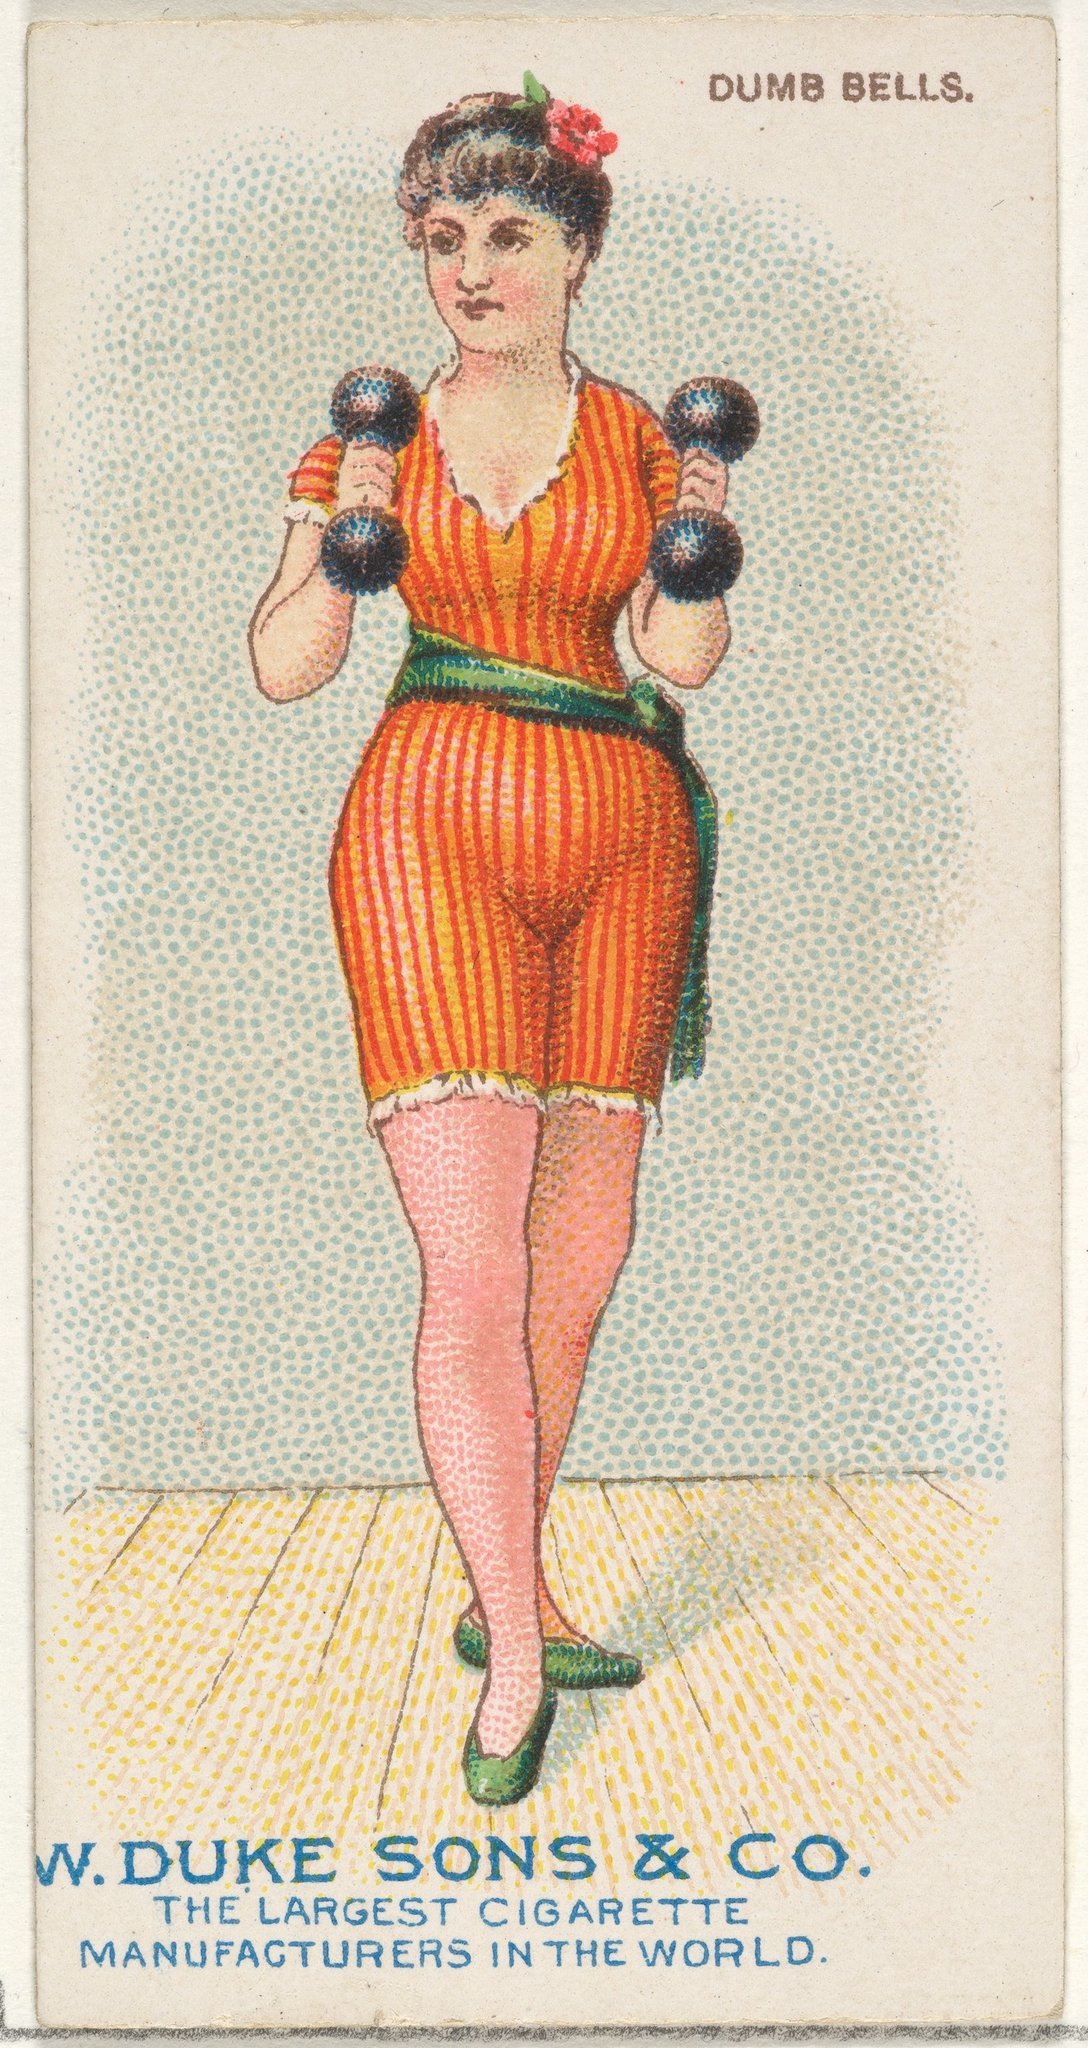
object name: print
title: Dumb Bells, from the Gymnastic Exercises series (N77) for Duke brand cigarettes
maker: w. duke, sons & co.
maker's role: publisher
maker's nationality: american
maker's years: 1870-1920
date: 1887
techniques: color lithograph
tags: women,athletes